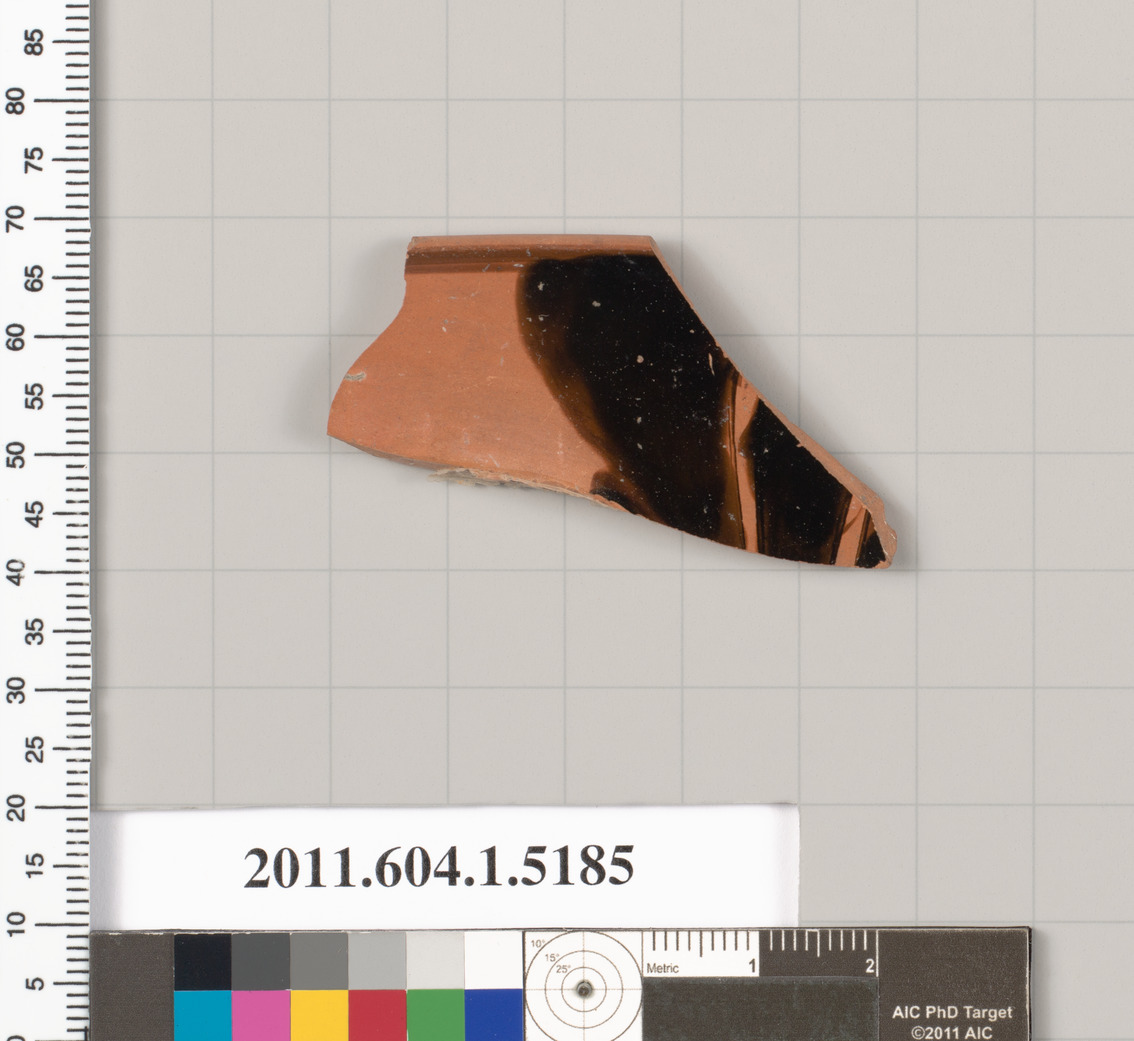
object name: kylix fragment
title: Terracotta rim fragment of a kylix (drinking cup)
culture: greek, attic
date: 475-451 BCE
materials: terracotta